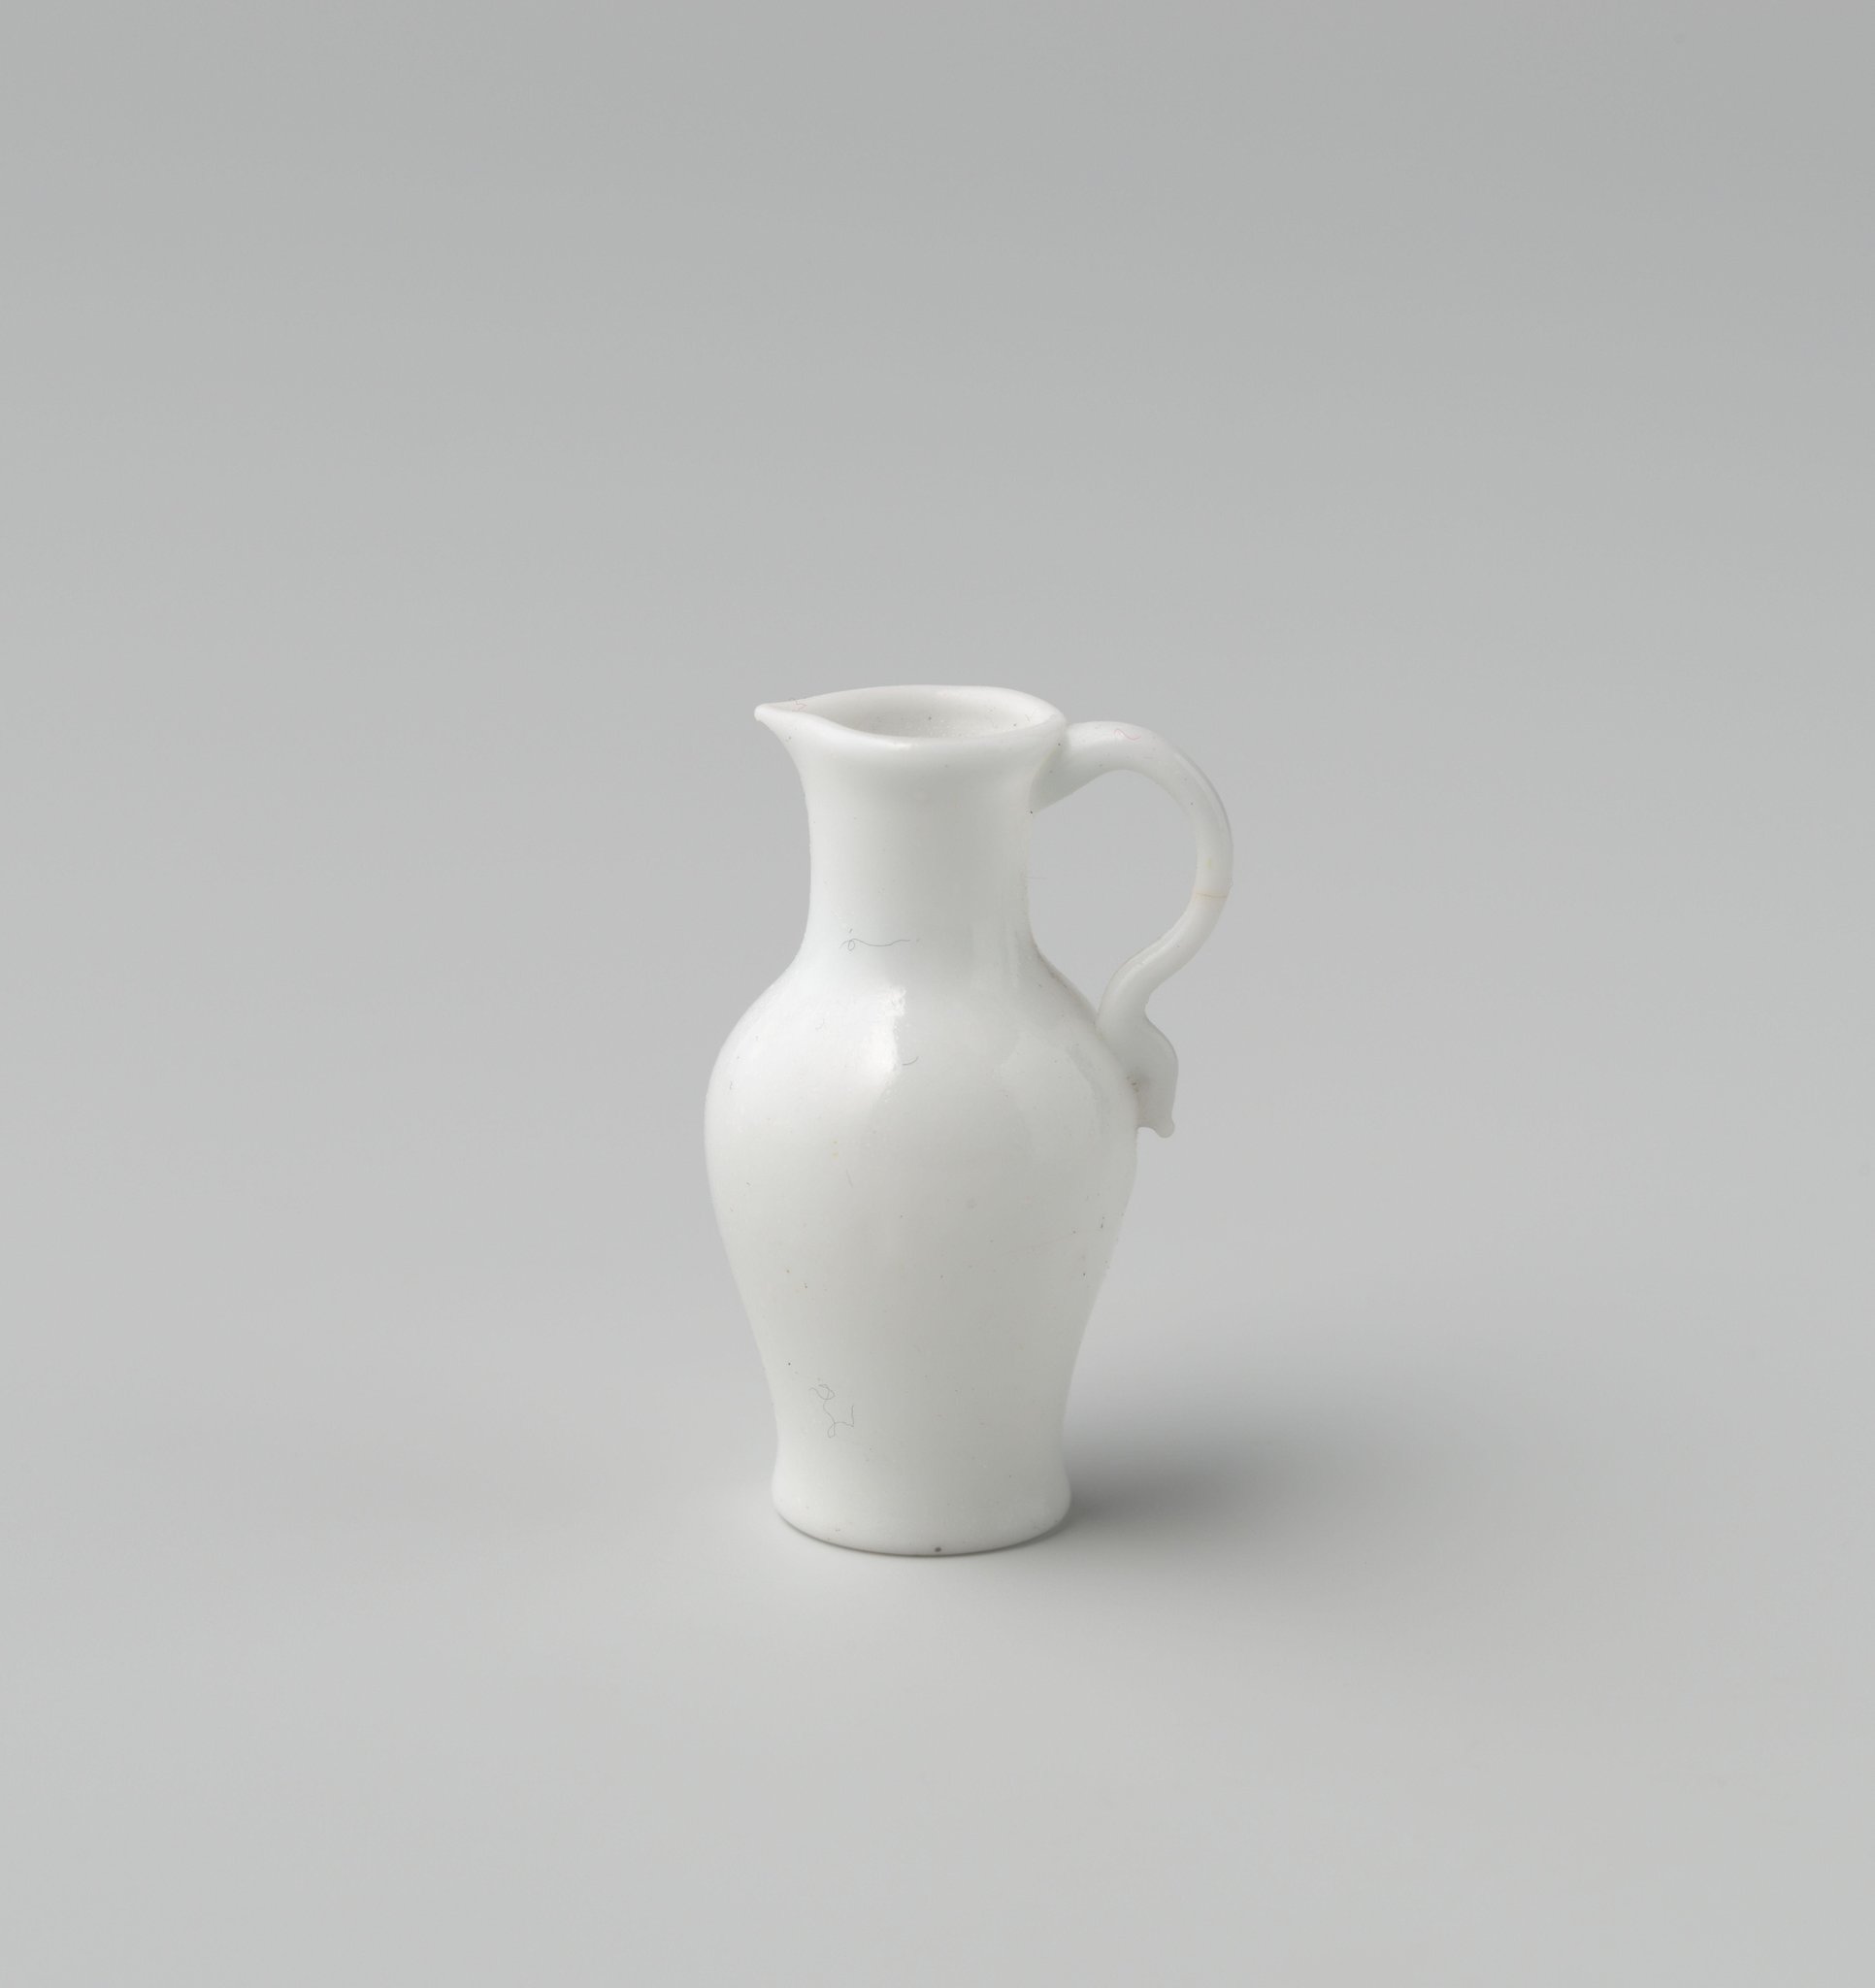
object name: flagon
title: Kan van opaak wit glas (waarschijnlijk imitatie wit aardewerk); hoge smal model met naar binnen gestoken bodem, een aangezet oor en schenklip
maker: Anonymous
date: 1675-1710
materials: glass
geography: amsterdam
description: Kan van opaak wit glas, waarschijnlijk imitatie wit aardewerk; hoge smal model met naar binnen gestoken bodem, een aangezet oor en schenklip.